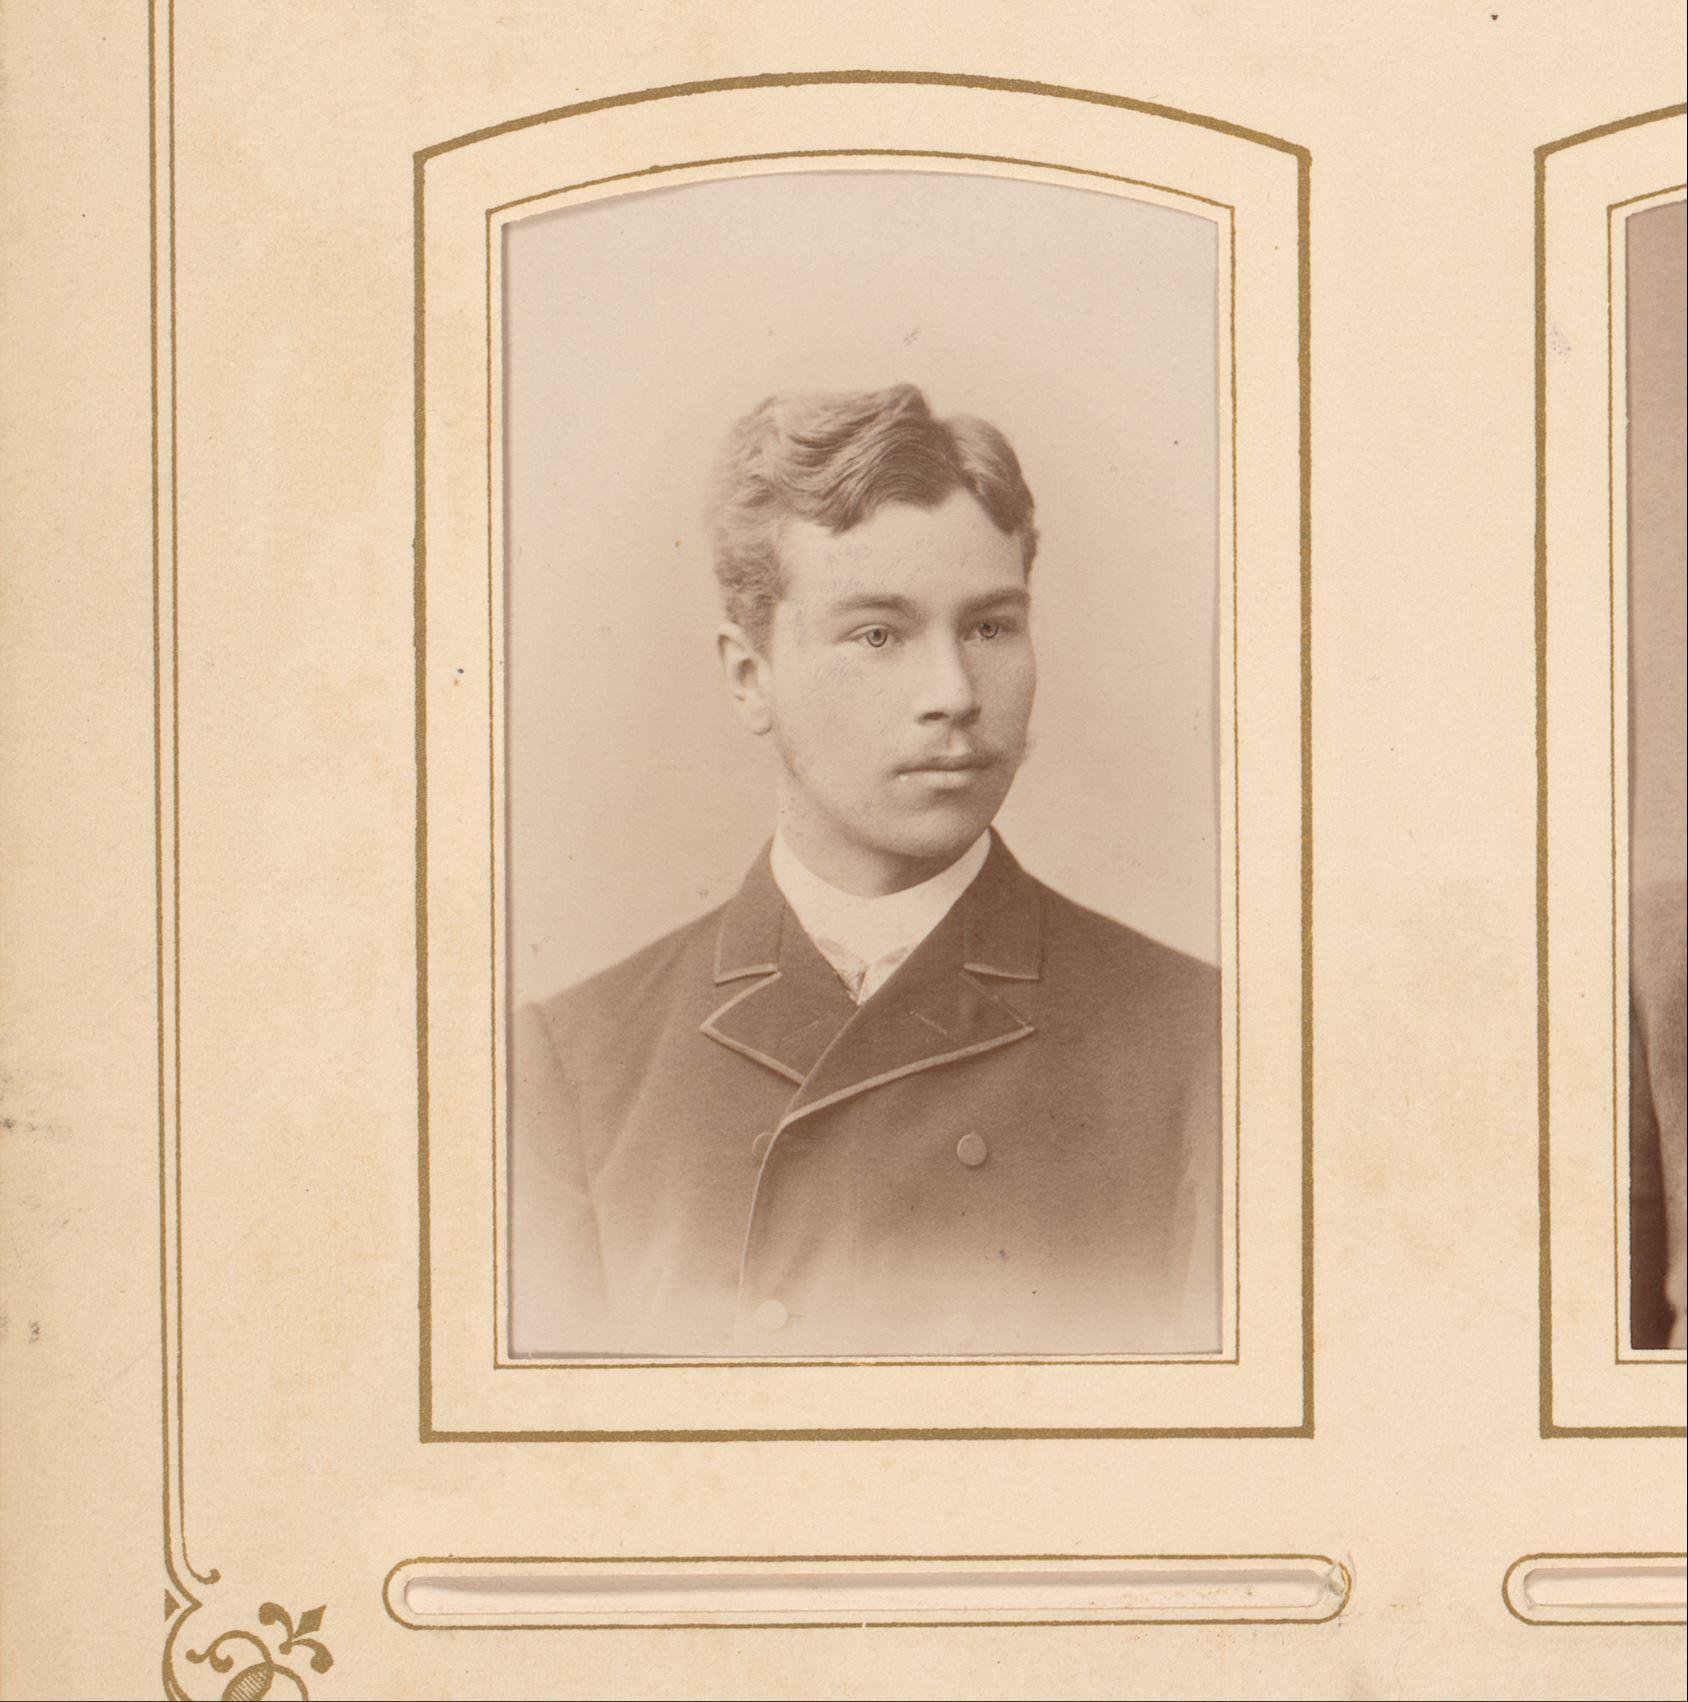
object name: photograph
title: Portret van een jonge man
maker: emil tiedemann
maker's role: fotograaf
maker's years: 1858-1892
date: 1859-1892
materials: cardboard, photographic support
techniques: albumen print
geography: bremen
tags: historical persons, youth, adolescent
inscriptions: annotation: ‘[...]/ [...]/ August Schütze/ [...]/ Erinnerung [...]/ Max Werner’, inscription: ‘EMIL TIEDEMANN/ HOF-PHOTOGRAPH (...) BREMEN/ Richtweg No. 12./ (...)/ Prämiirt Utrecht, Hamburg, Sidney, Eisenach u.s.w.’